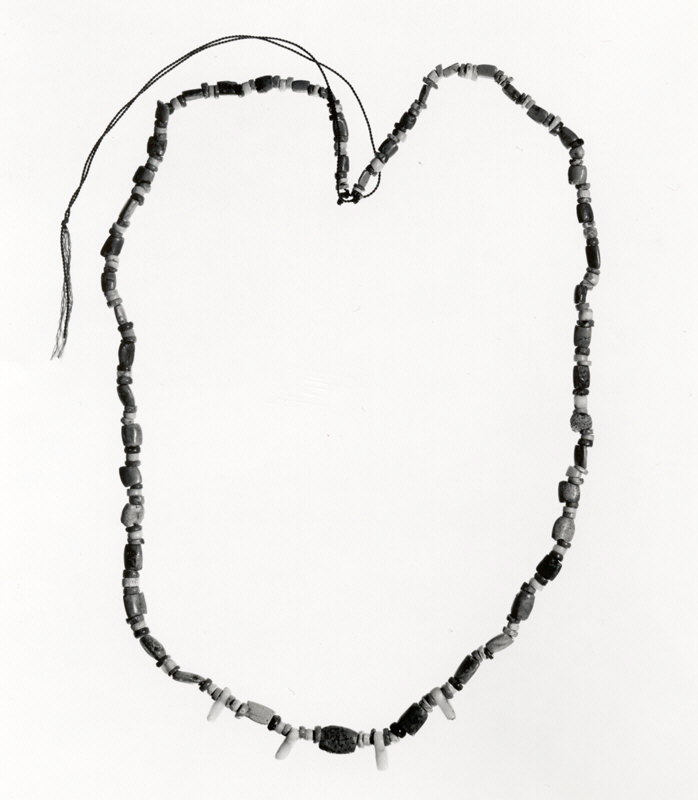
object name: necklace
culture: bactria-margiana archaeological complex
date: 2333-1668 BCE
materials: stone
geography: bactria-margiana